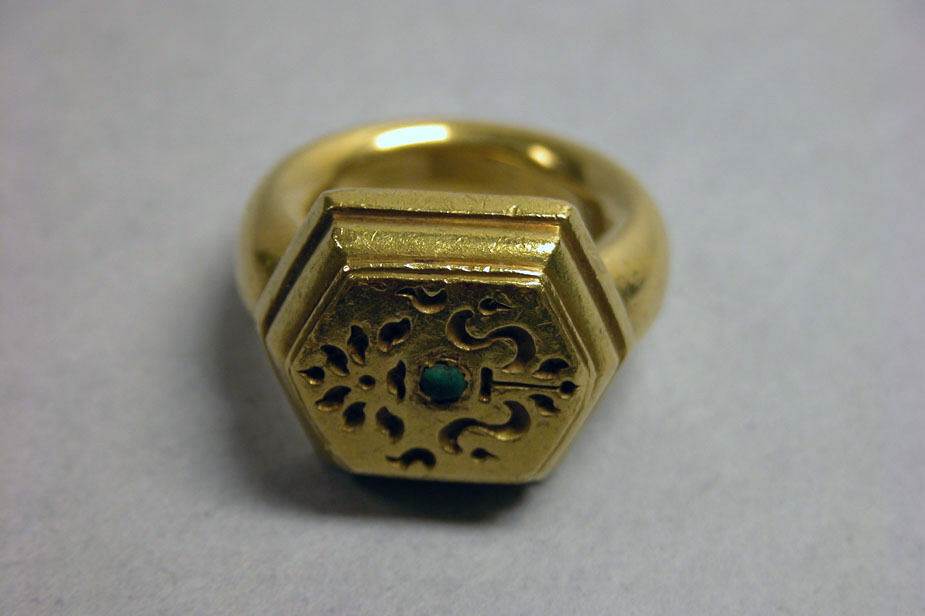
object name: ring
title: Ring with Hexagonal Bezel and Stone with "Sri" Inscription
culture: indonesian, javanese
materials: gold, stone